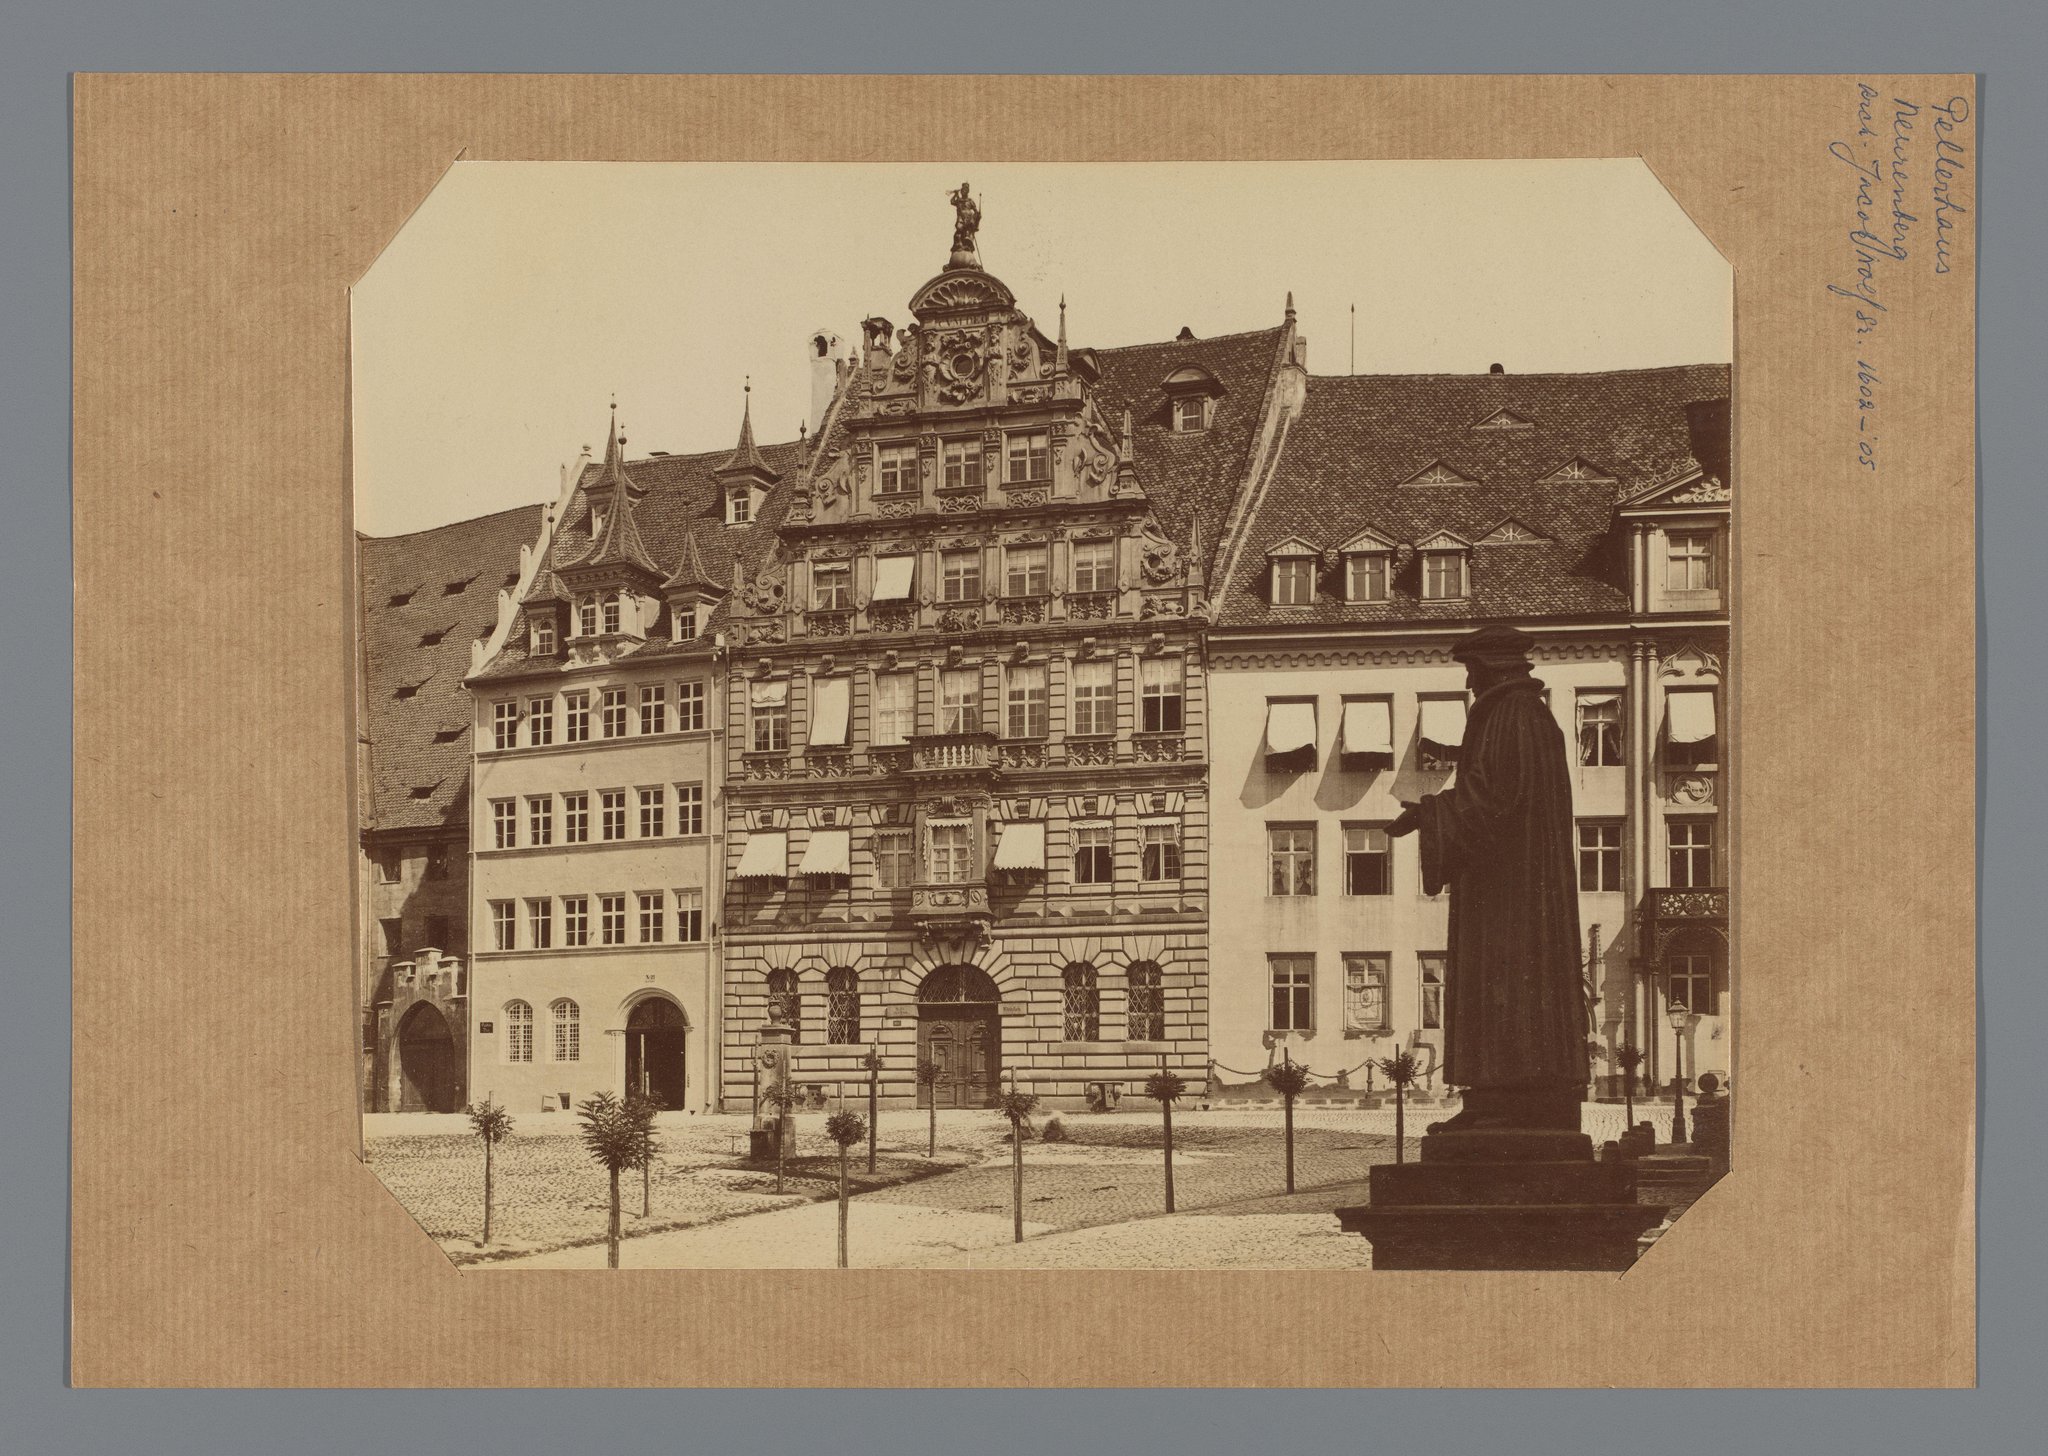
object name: photograph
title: Neurenberg, Pellerhaus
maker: Anonymous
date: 1850-1890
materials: photographic support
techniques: albumen print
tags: pellerhaus